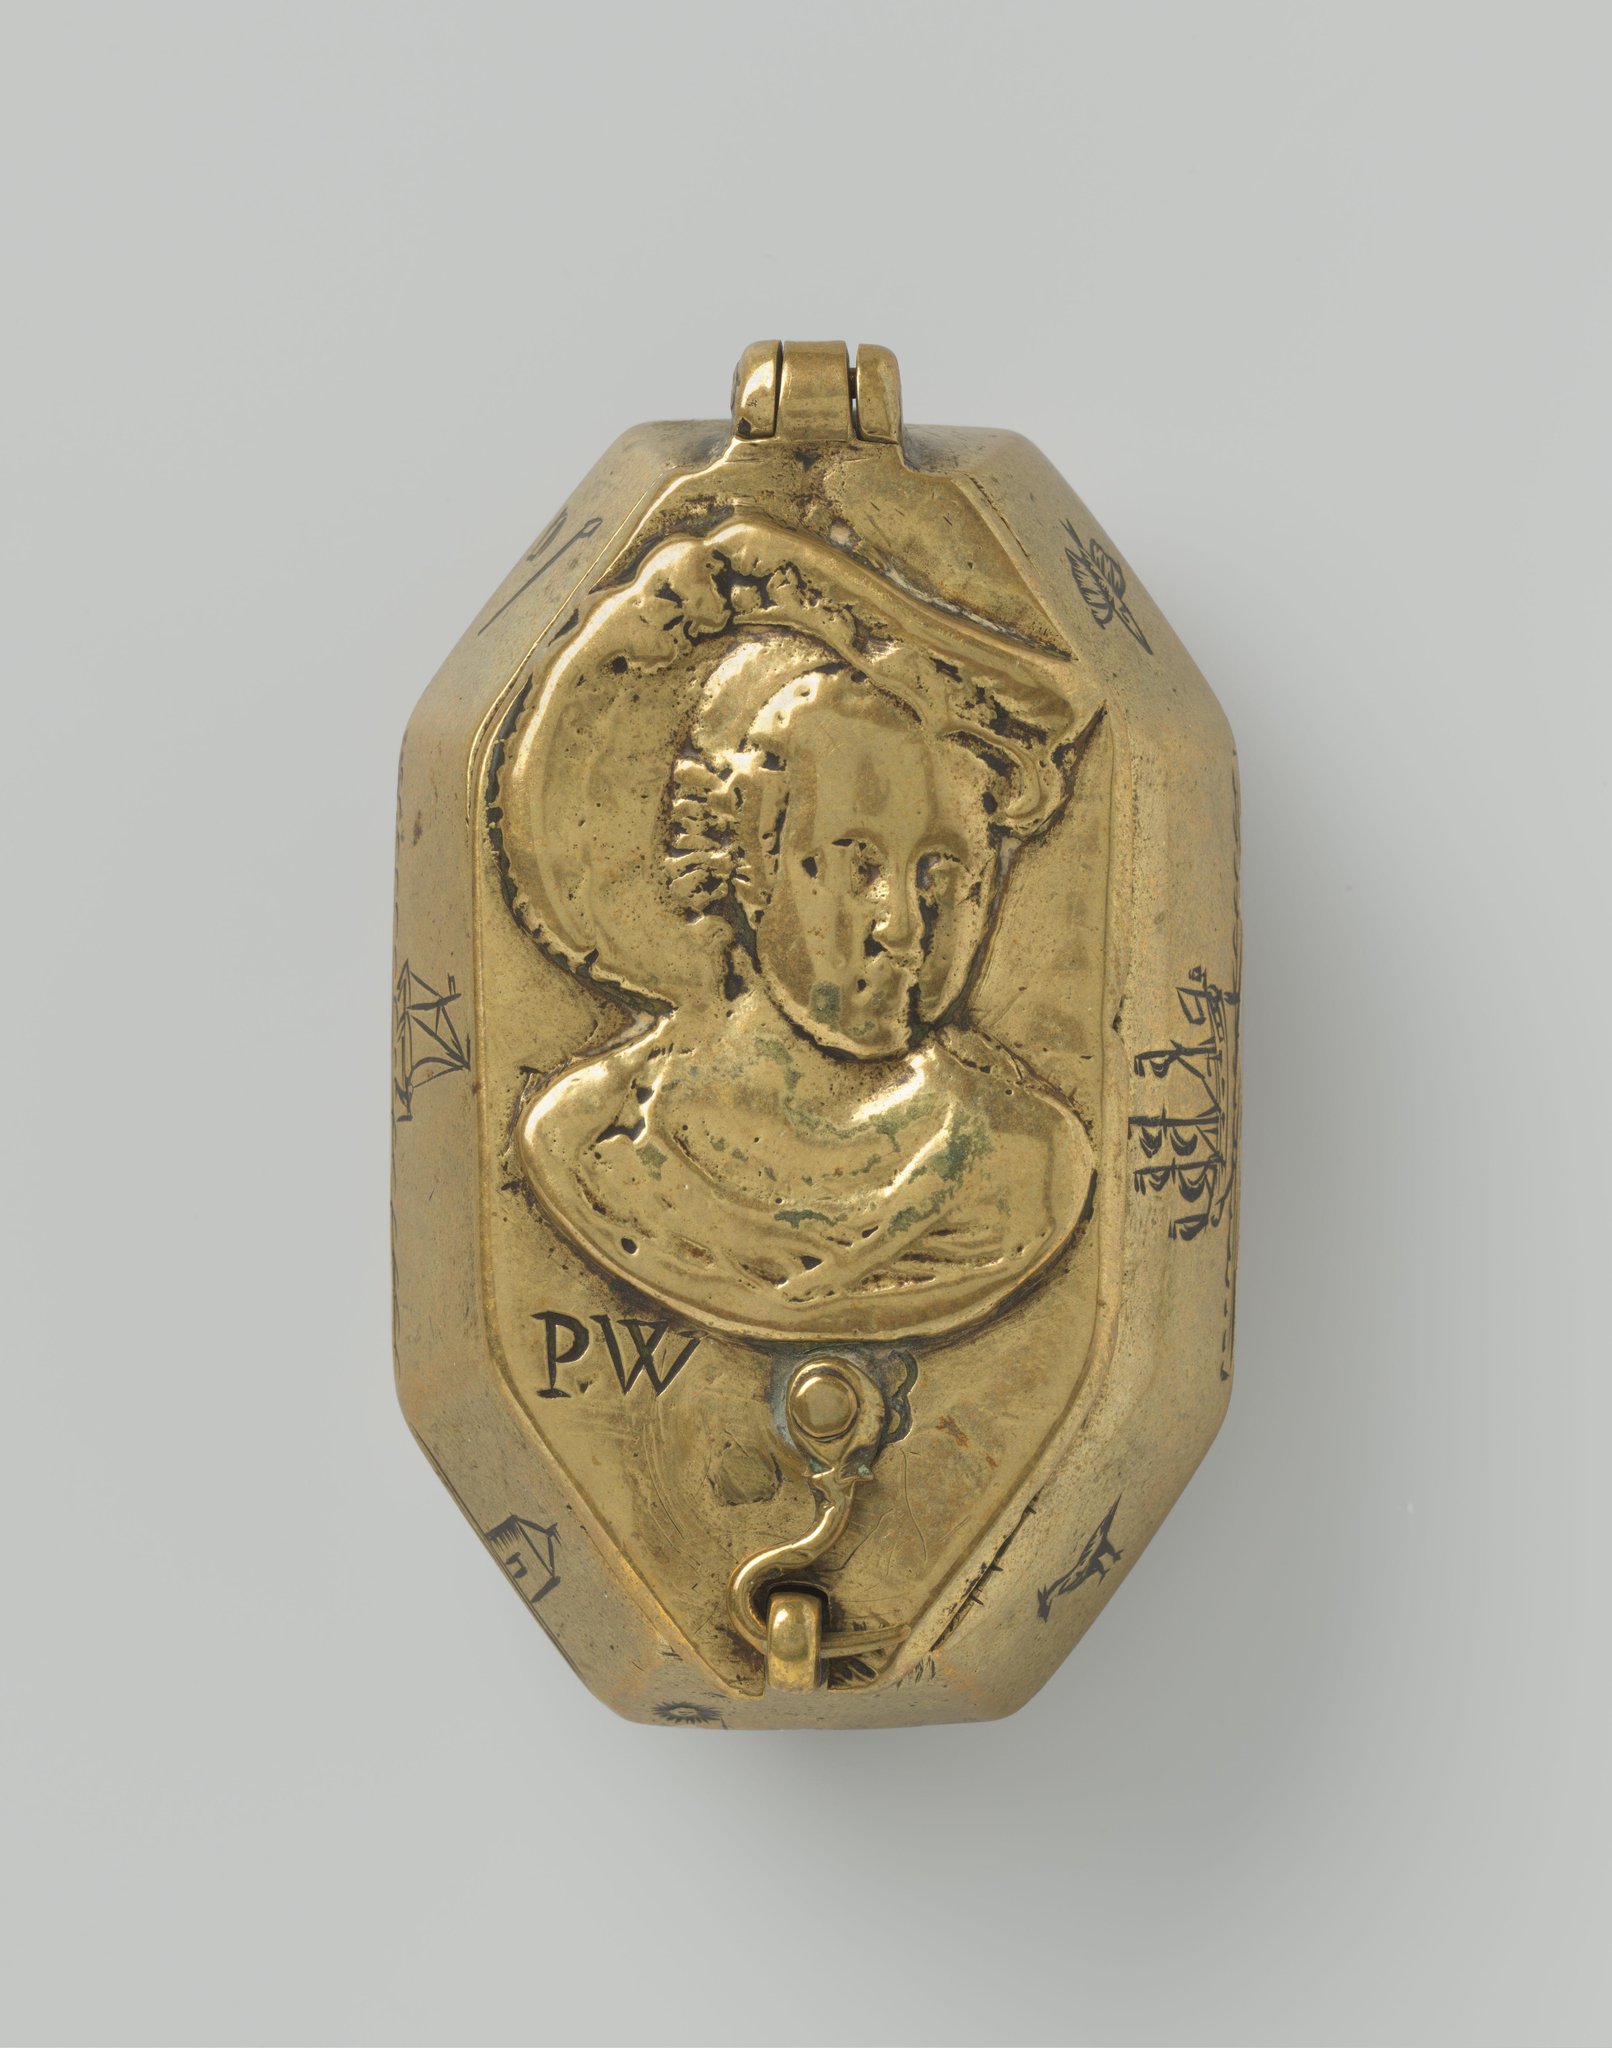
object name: medal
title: Koperen doosje met afbeelding van prins Willem III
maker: Anonymous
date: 1650-1675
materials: copper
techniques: casting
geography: netherlands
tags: the hague, william iii (prince of orange and king of england, scotland, and ireland)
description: Achthoekig koperen doosje met aan bovenzijde op deksel portret van prins Willem III en op bodem meegegoten afdruk van penning van prins Maurits met de voorstelling van een boom. Met ingegraveerde inscripties en afbeeldingen.